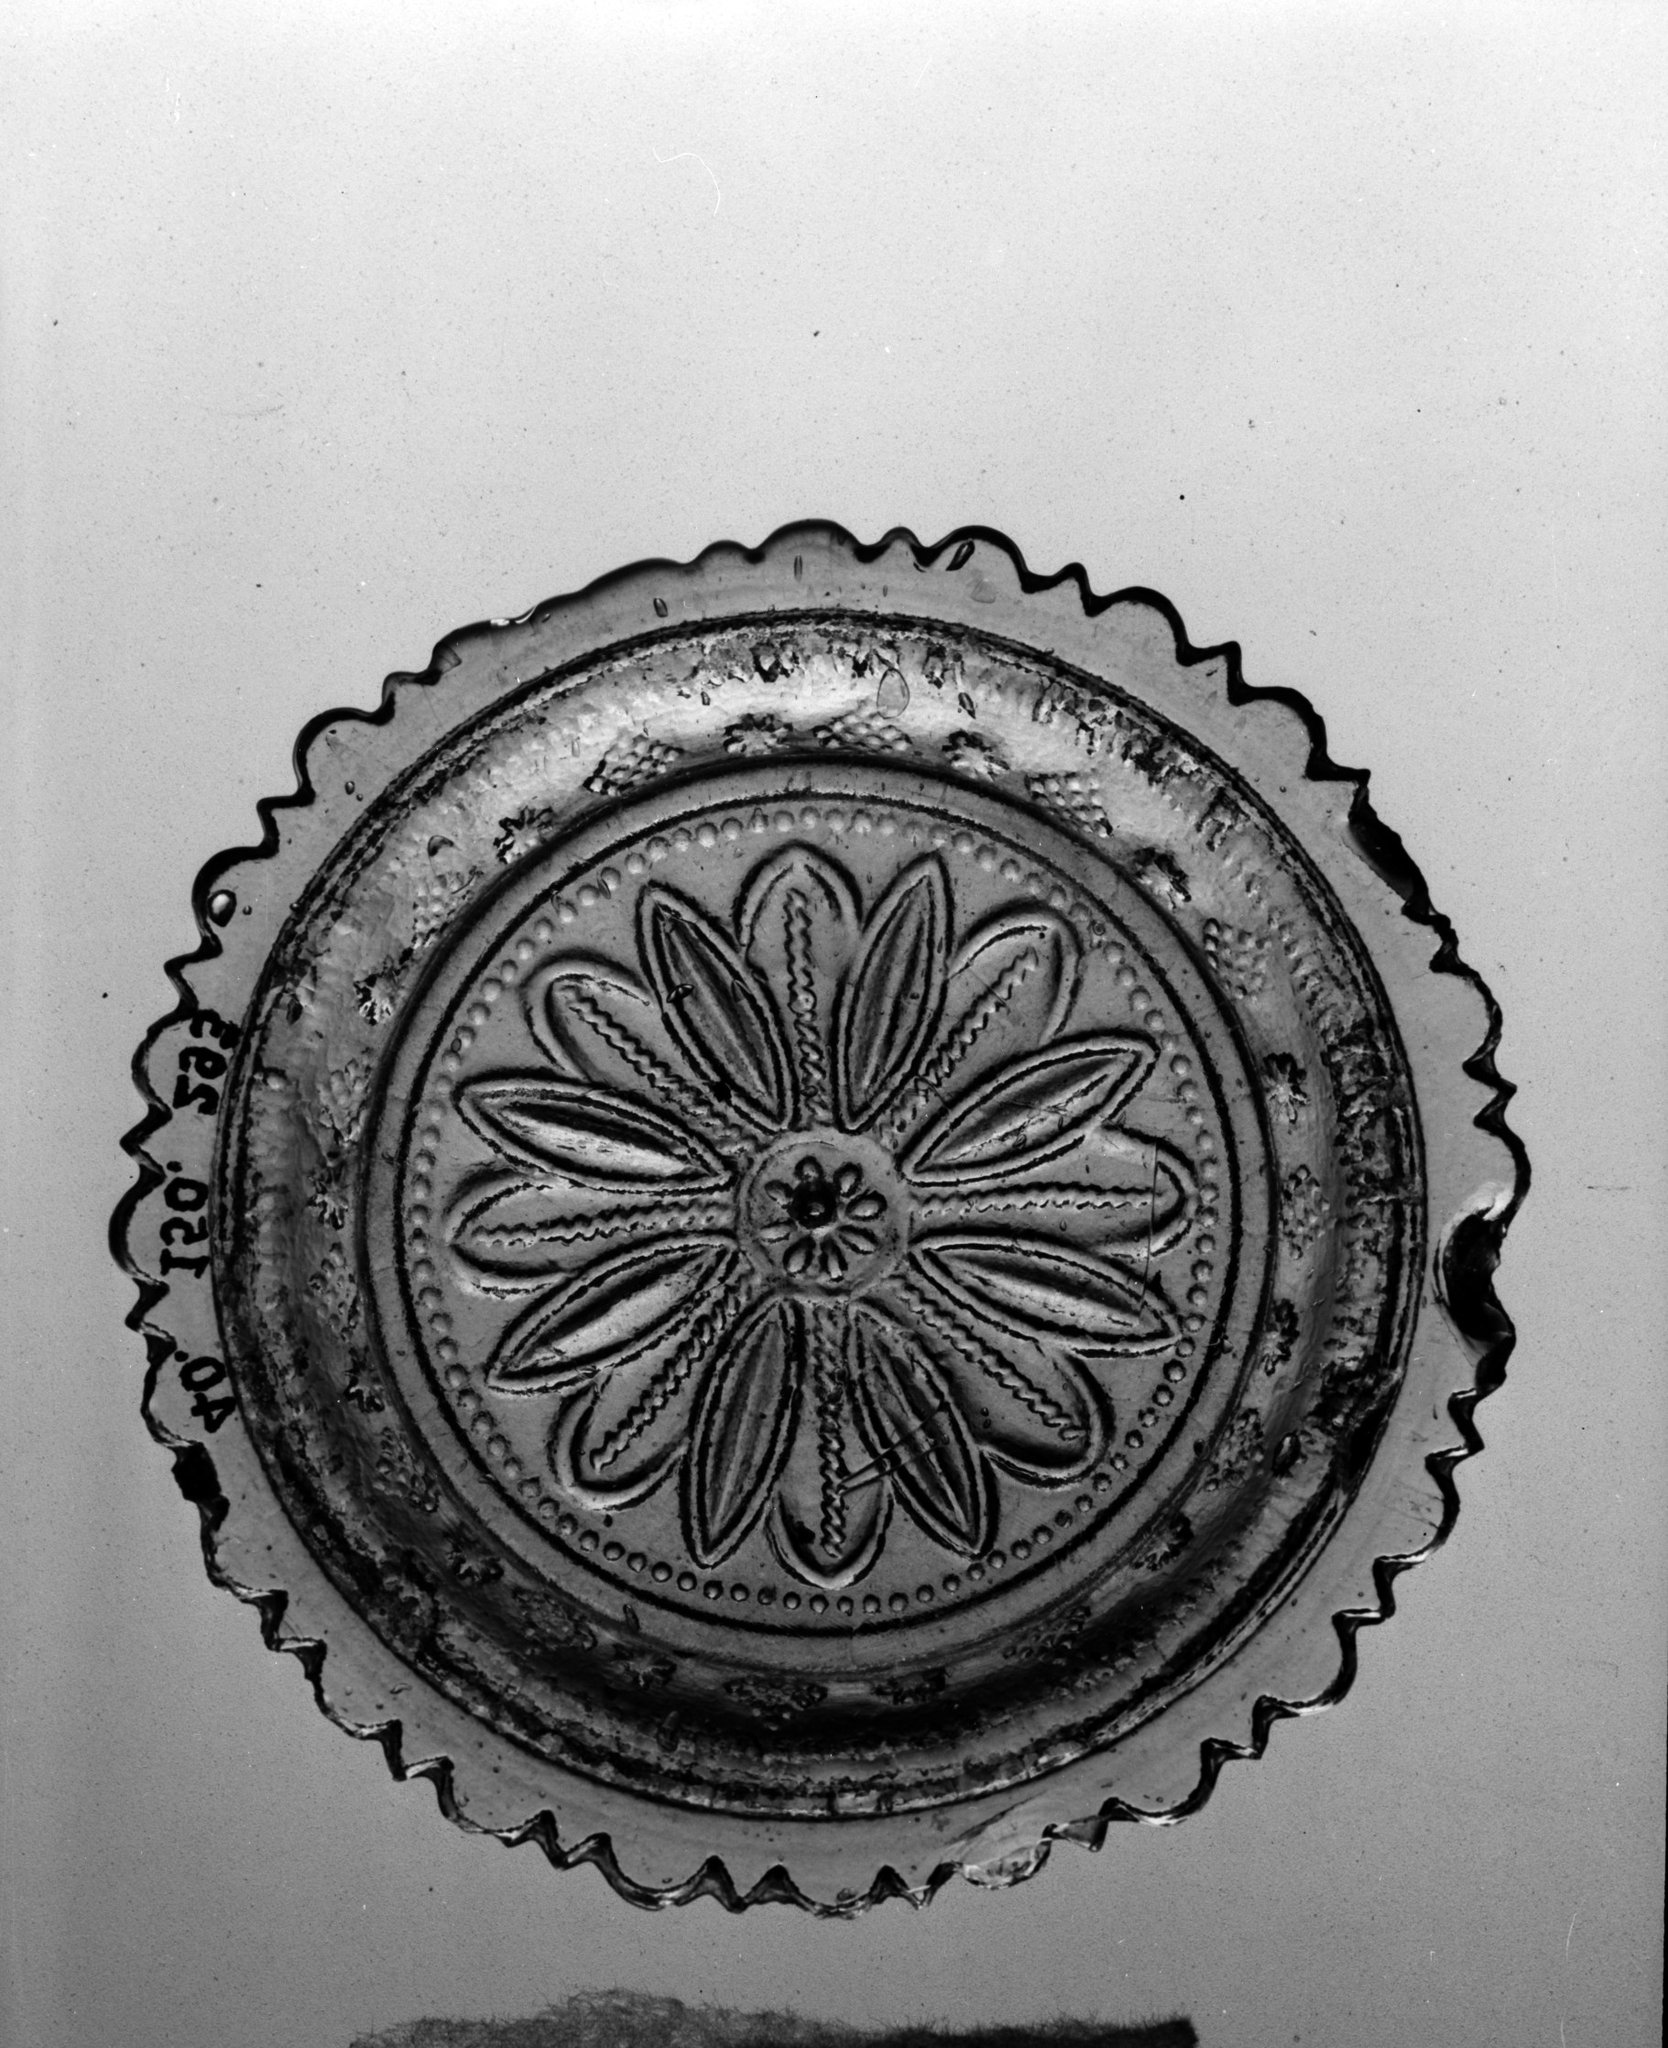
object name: cup plate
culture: american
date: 1830-1850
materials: glass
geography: united states